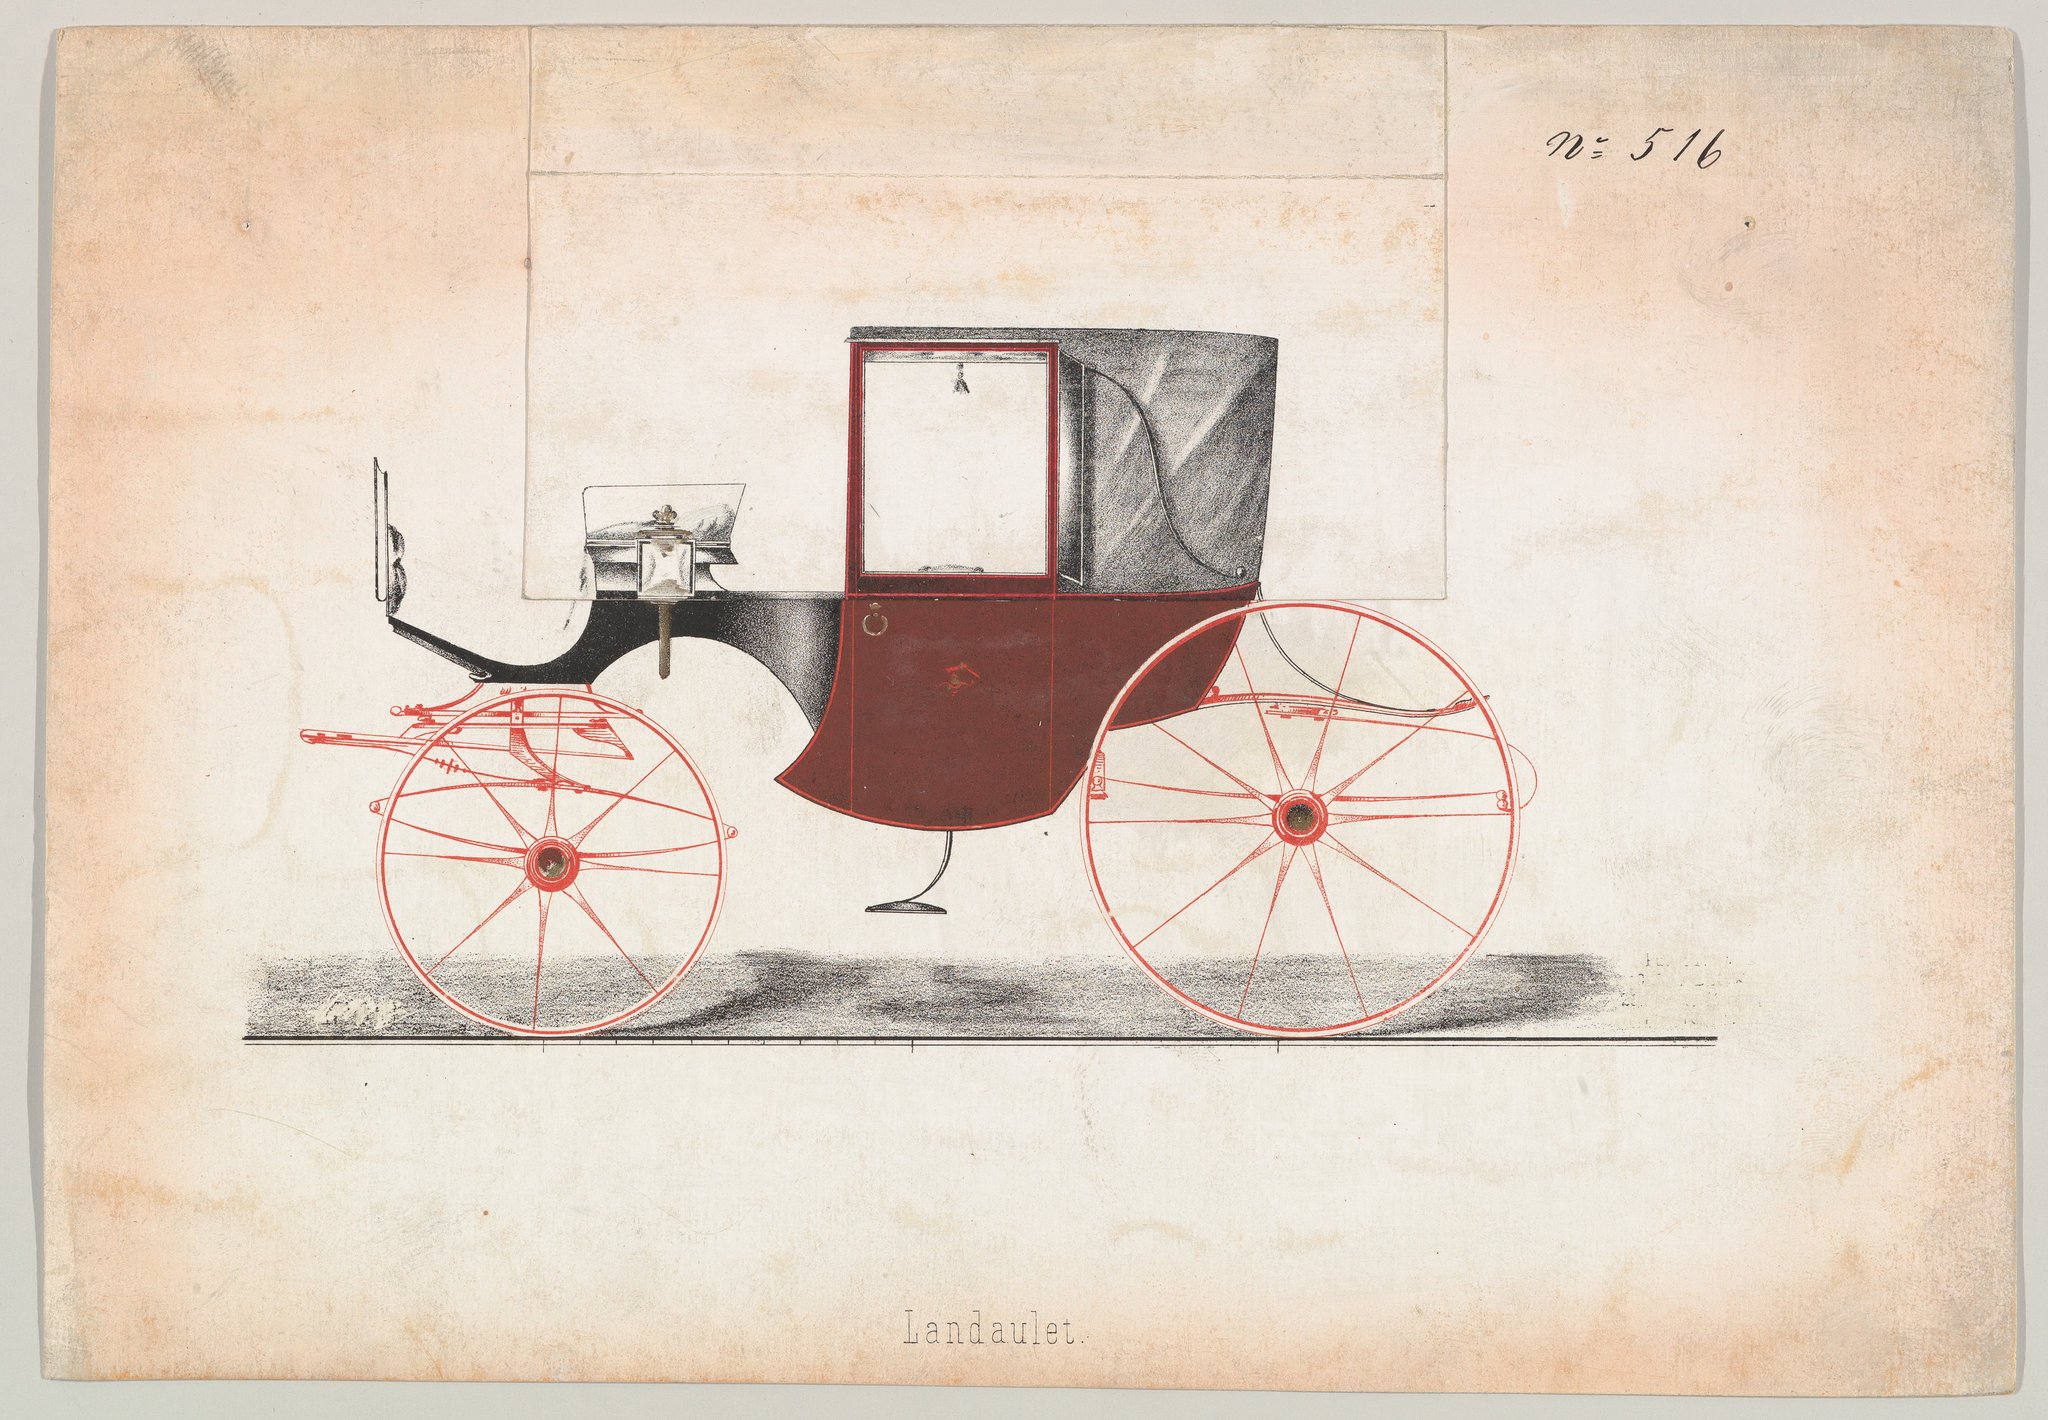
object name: drawing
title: Landaulet #516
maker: brewster & co.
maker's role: manufacturer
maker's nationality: american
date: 1860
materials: gouache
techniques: hand coloring, lithograph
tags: carriages